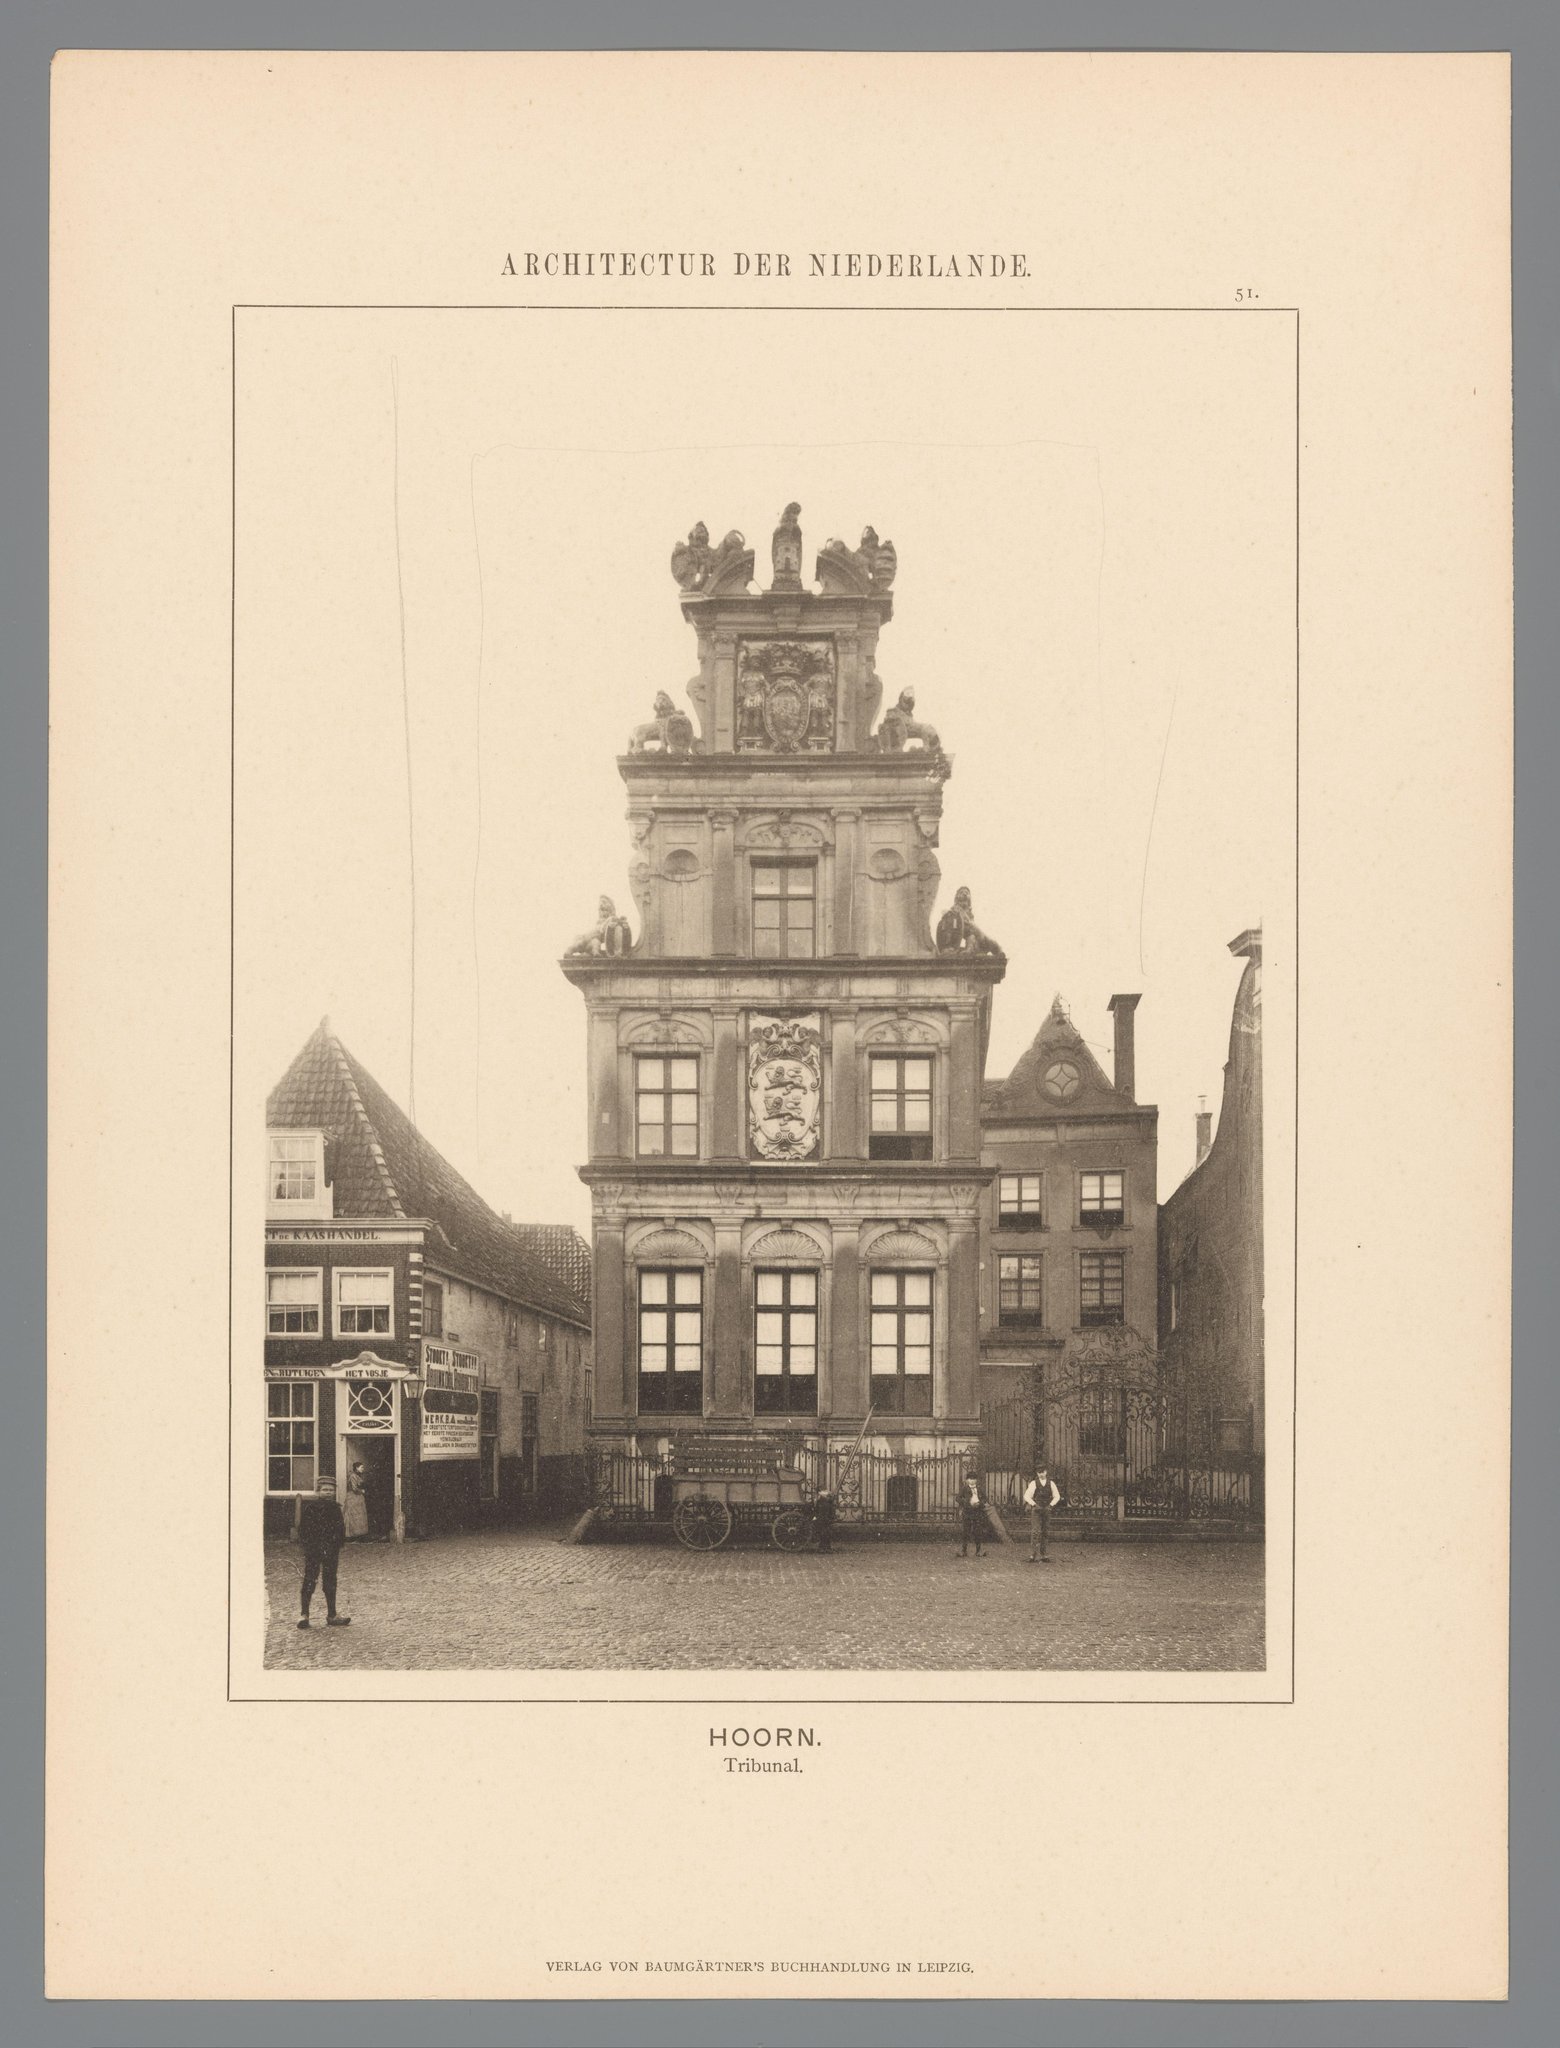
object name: book illustration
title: Architectur der Niederlande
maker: Anonymous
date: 1894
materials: paper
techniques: photograph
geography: leipzig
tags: court building, hoorn (north holland)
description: Afdruk uit: Krook, L. Architectur der Niederlande. Leipzig: Baumgärtner's Buchhandlung, 1894.